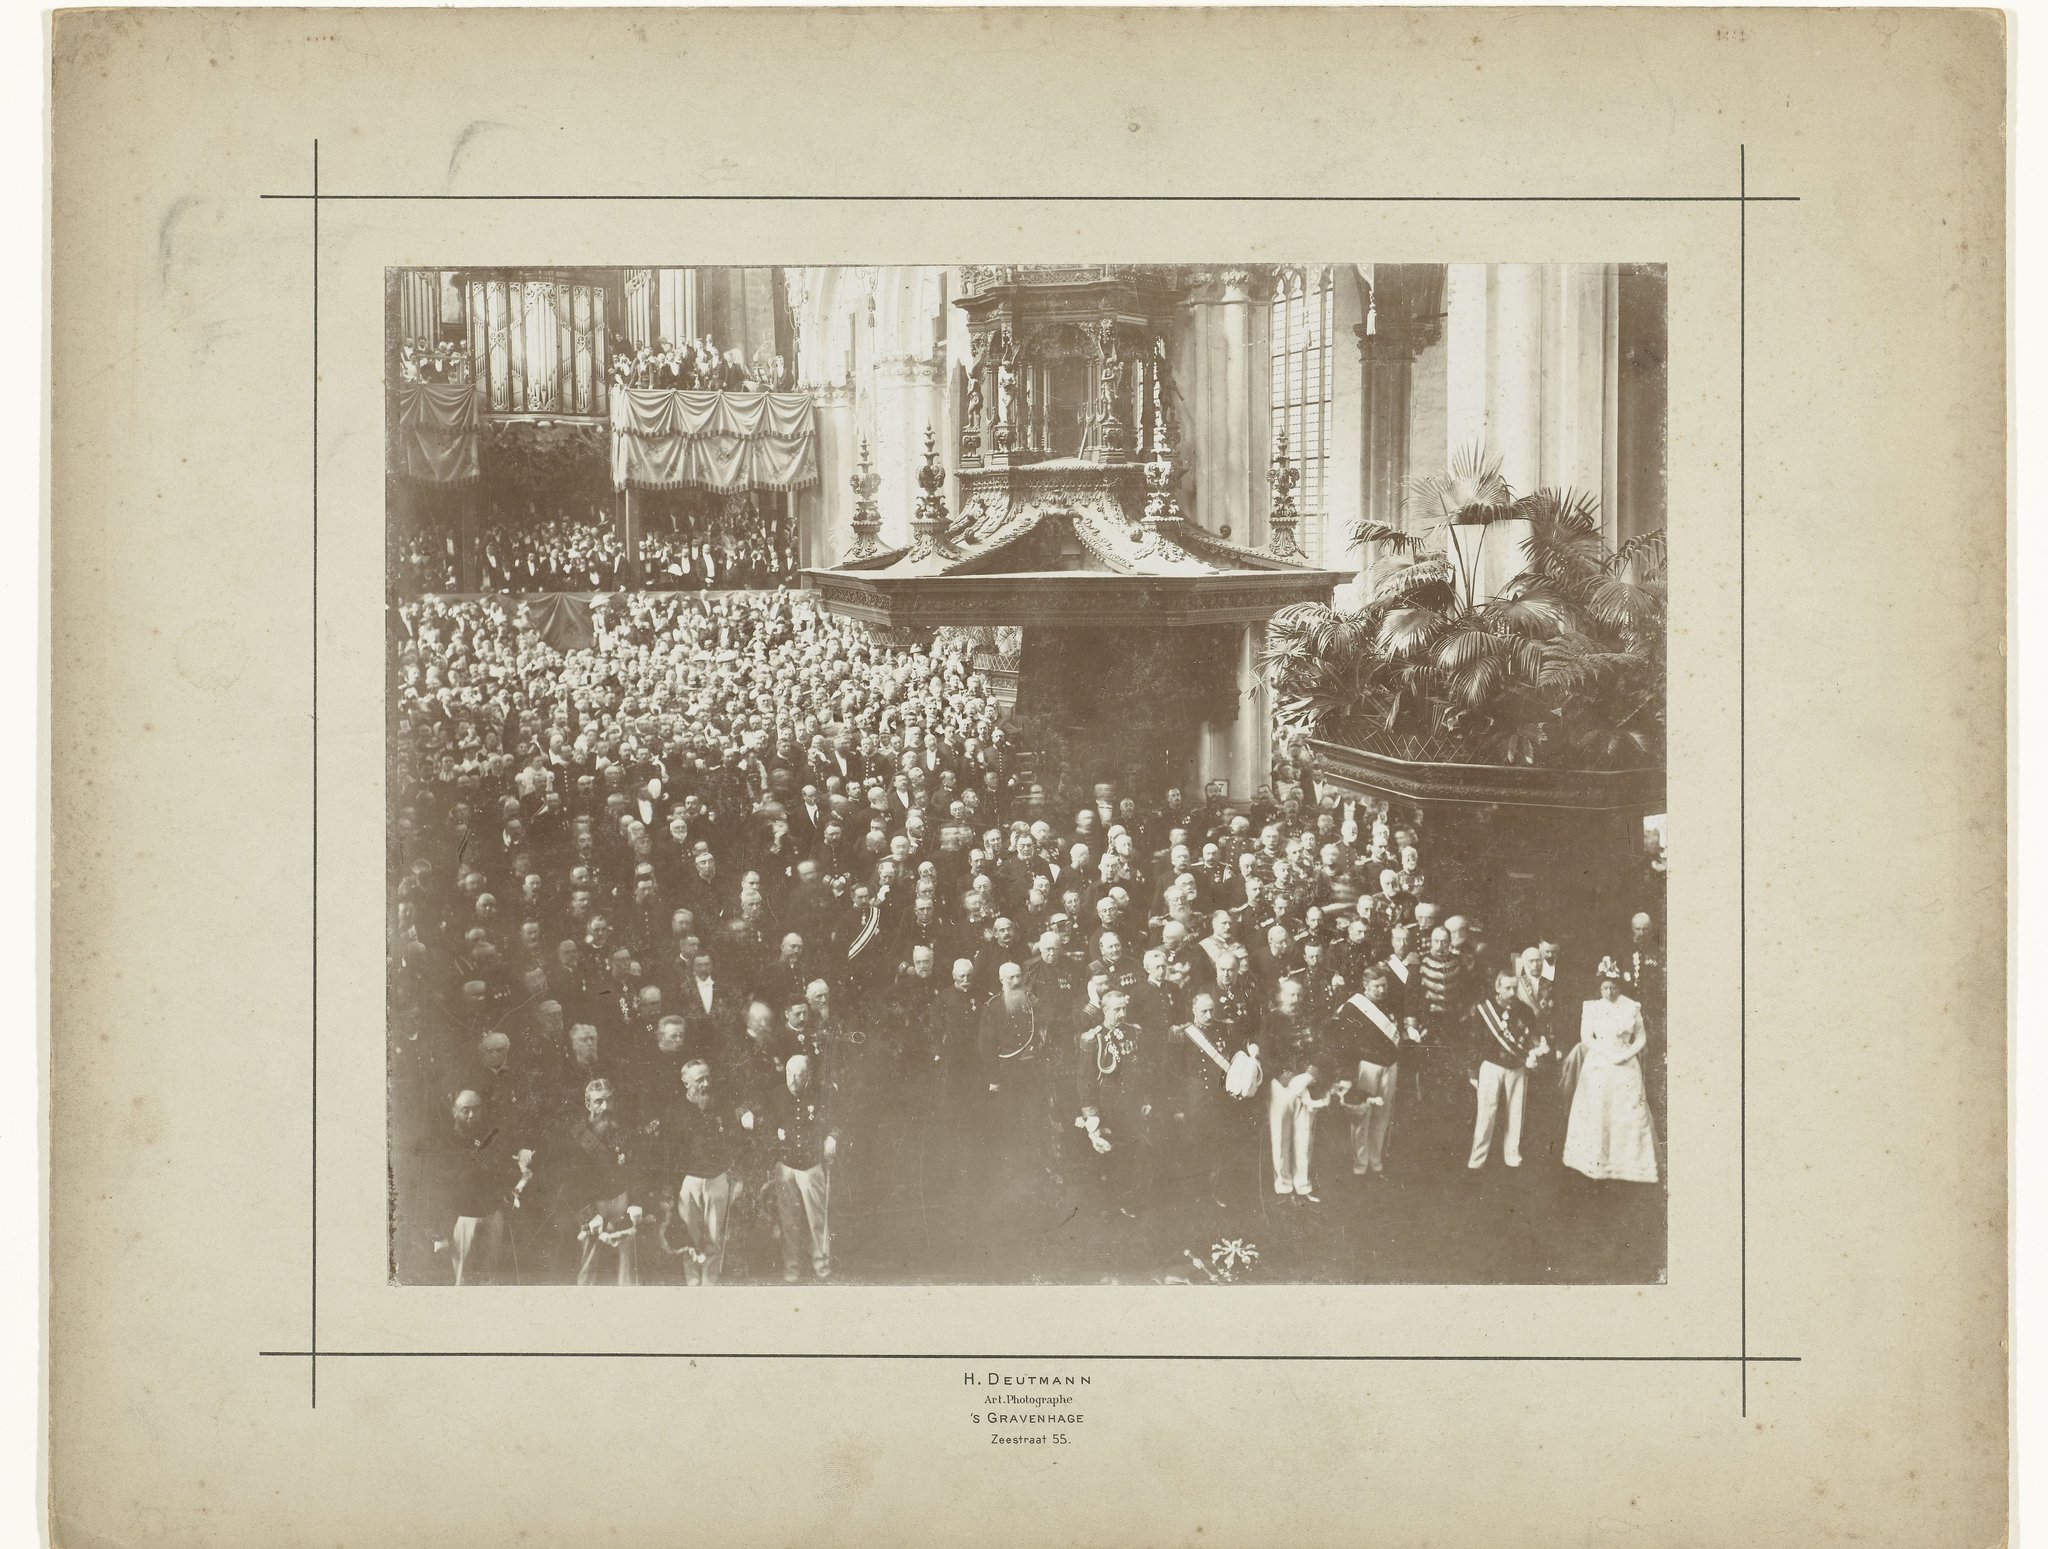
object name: photograph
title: Inhuldiging koningin Wilhelmina in de Nieuwe Kerk te Amsterdam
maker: herman deutmann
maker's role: fotograaf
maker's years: 1870-1926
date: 1898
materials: cardboard, photographic support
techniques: collodion silver print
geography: the hague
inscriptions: stamp: ‘H.Deutmann//Art.Photographe//'s Gravenhage//Zeestraat 55.’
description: Inhuldiging koningin Wilhelmina in de Nieuwe Kerk te Amsterdam. Gezicht op de aanwezigen vanaf een verhoogd standpunt in de buurt van het altaar (?).